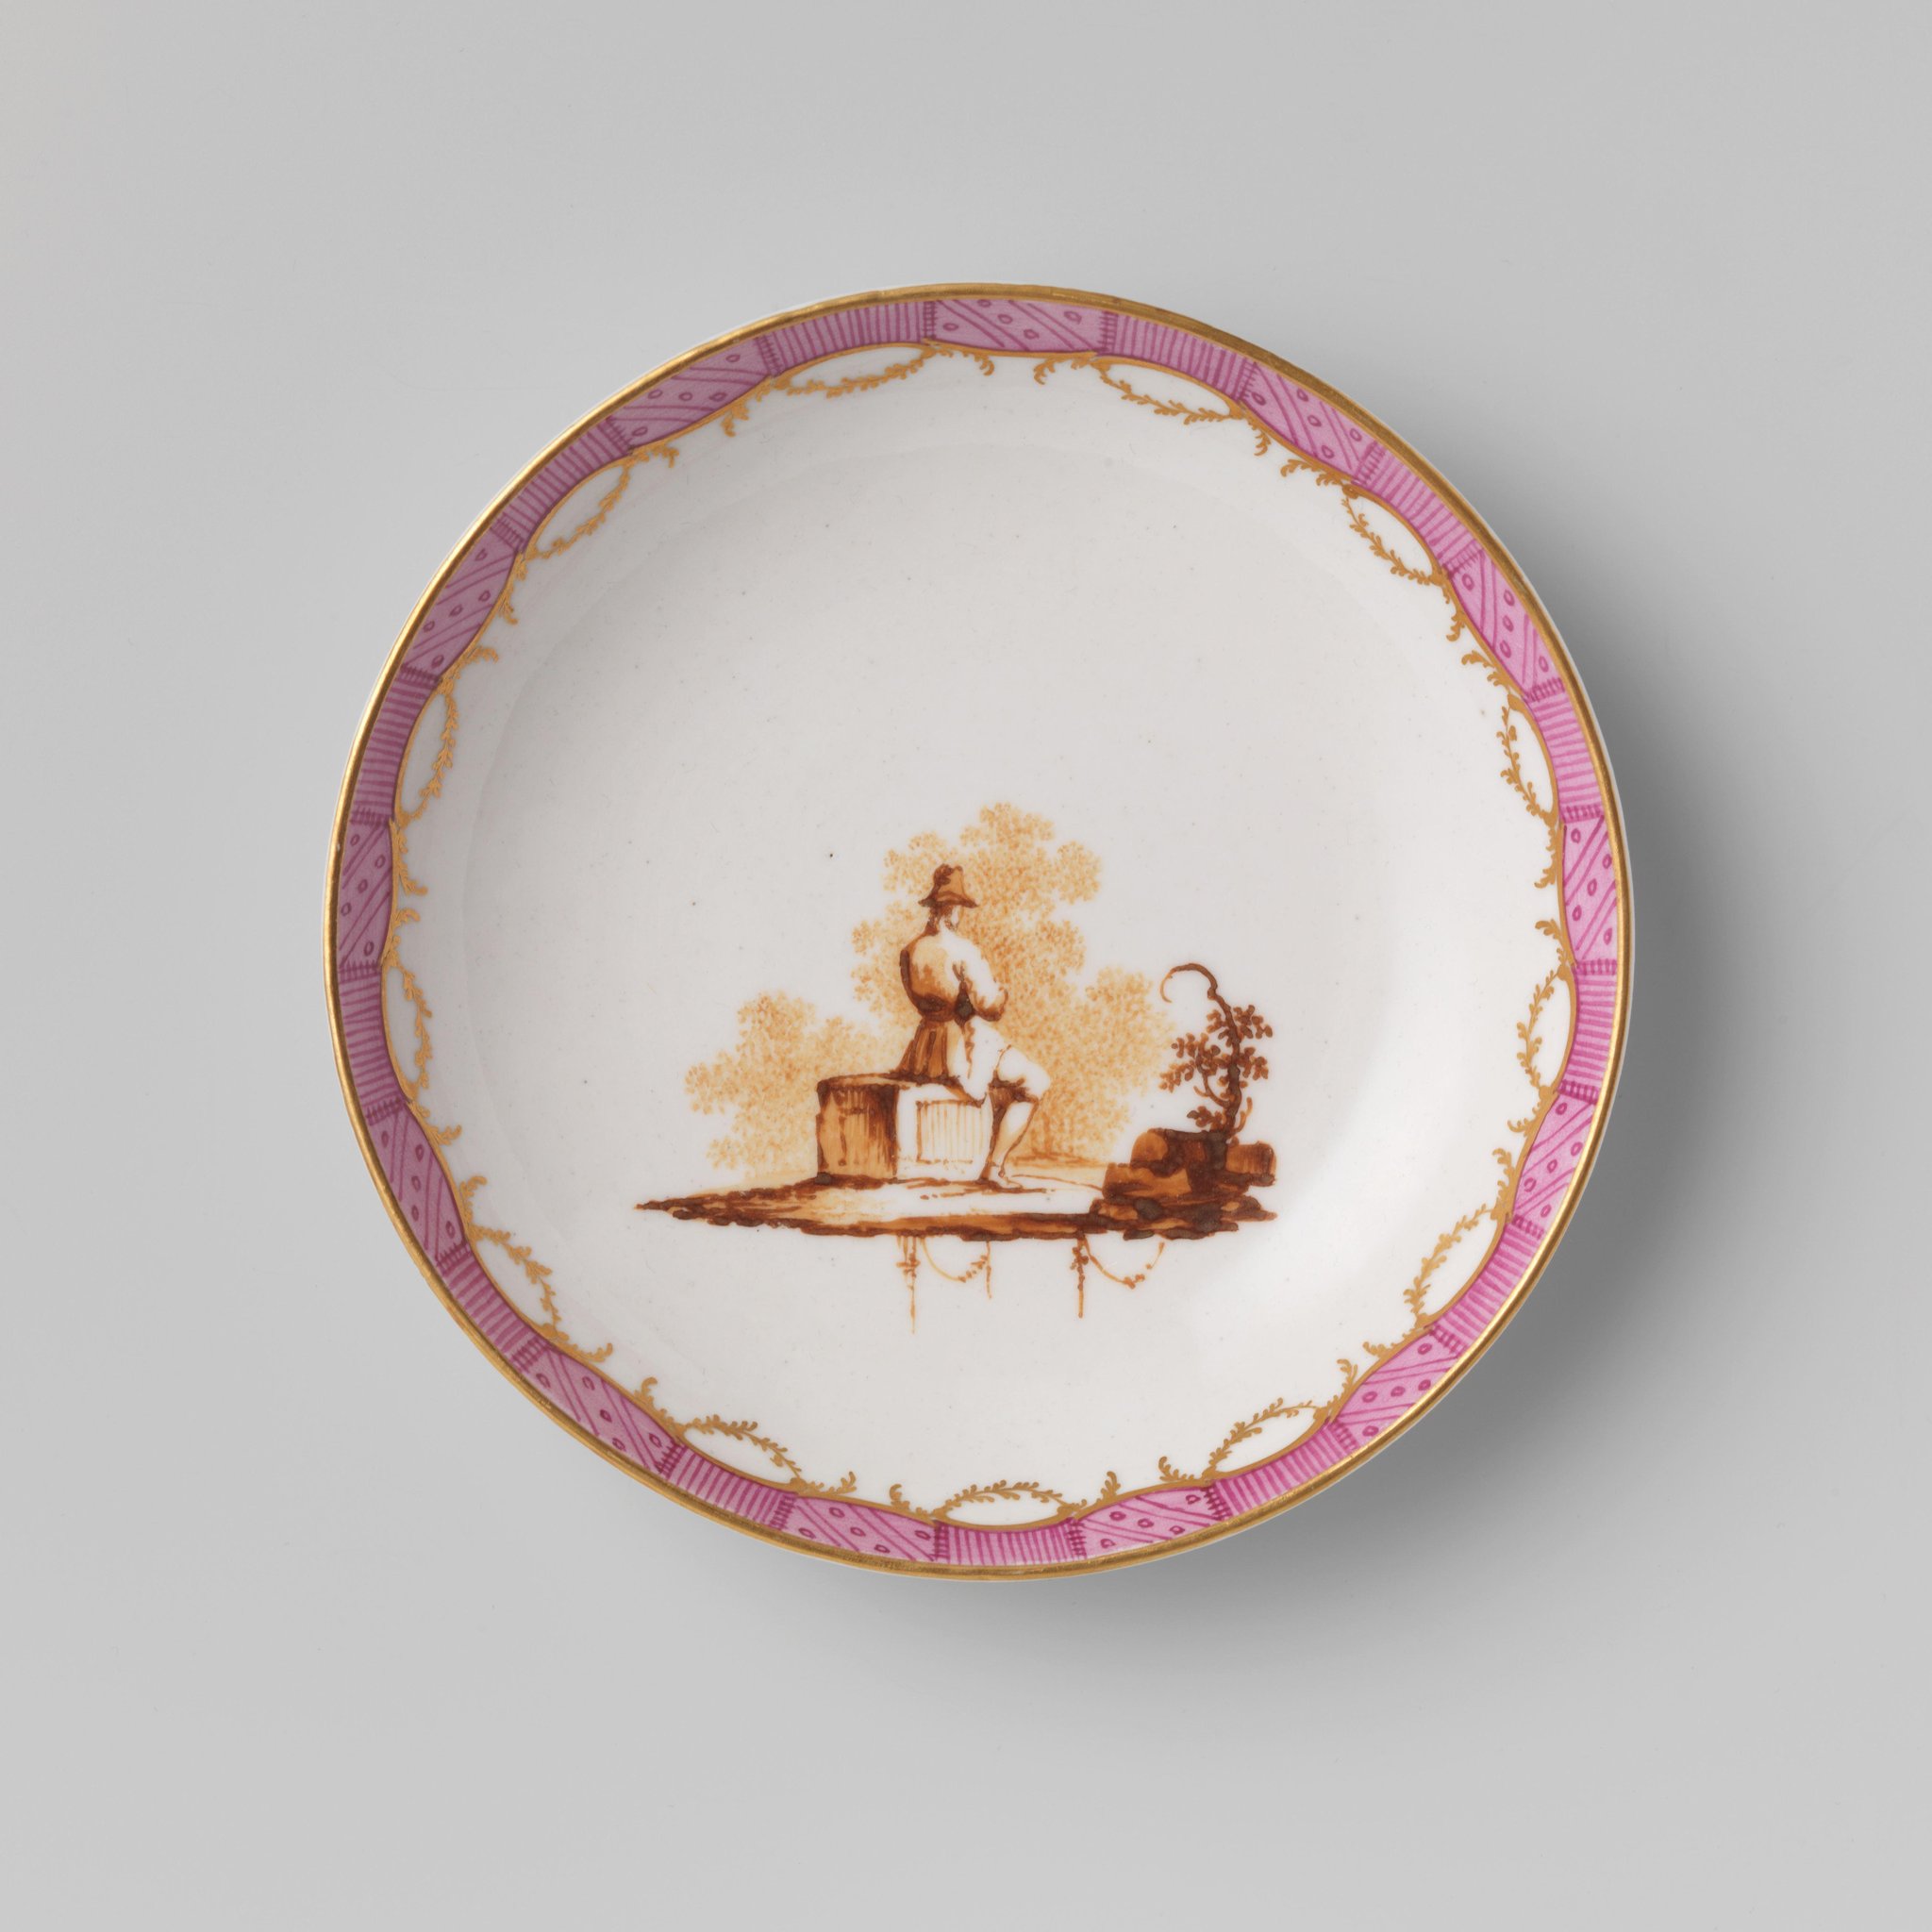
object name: platter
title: Schotel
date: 1774-1778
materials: porcelain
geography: loosdrecht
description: Schotel van porselein. Beschilderd in sepia met figuren in een landschap. Langs de rand een lila fries tussen gouden biezen.